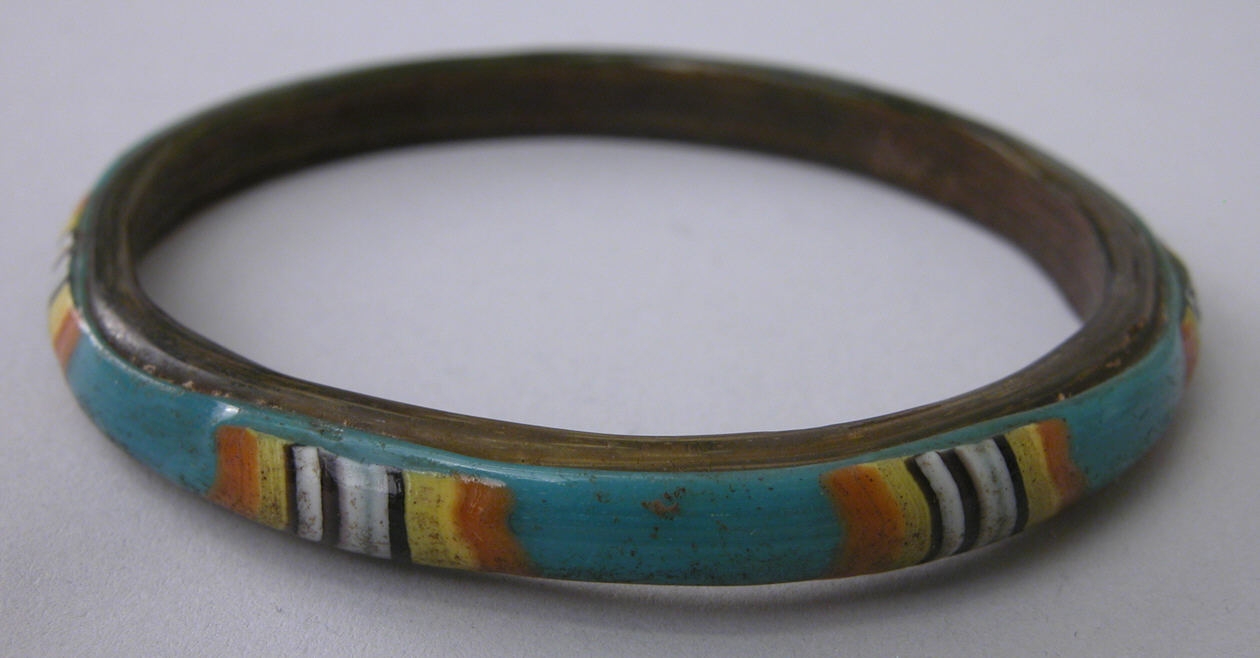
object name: bracelet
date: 1301-1500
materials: glass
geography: egypt or syria